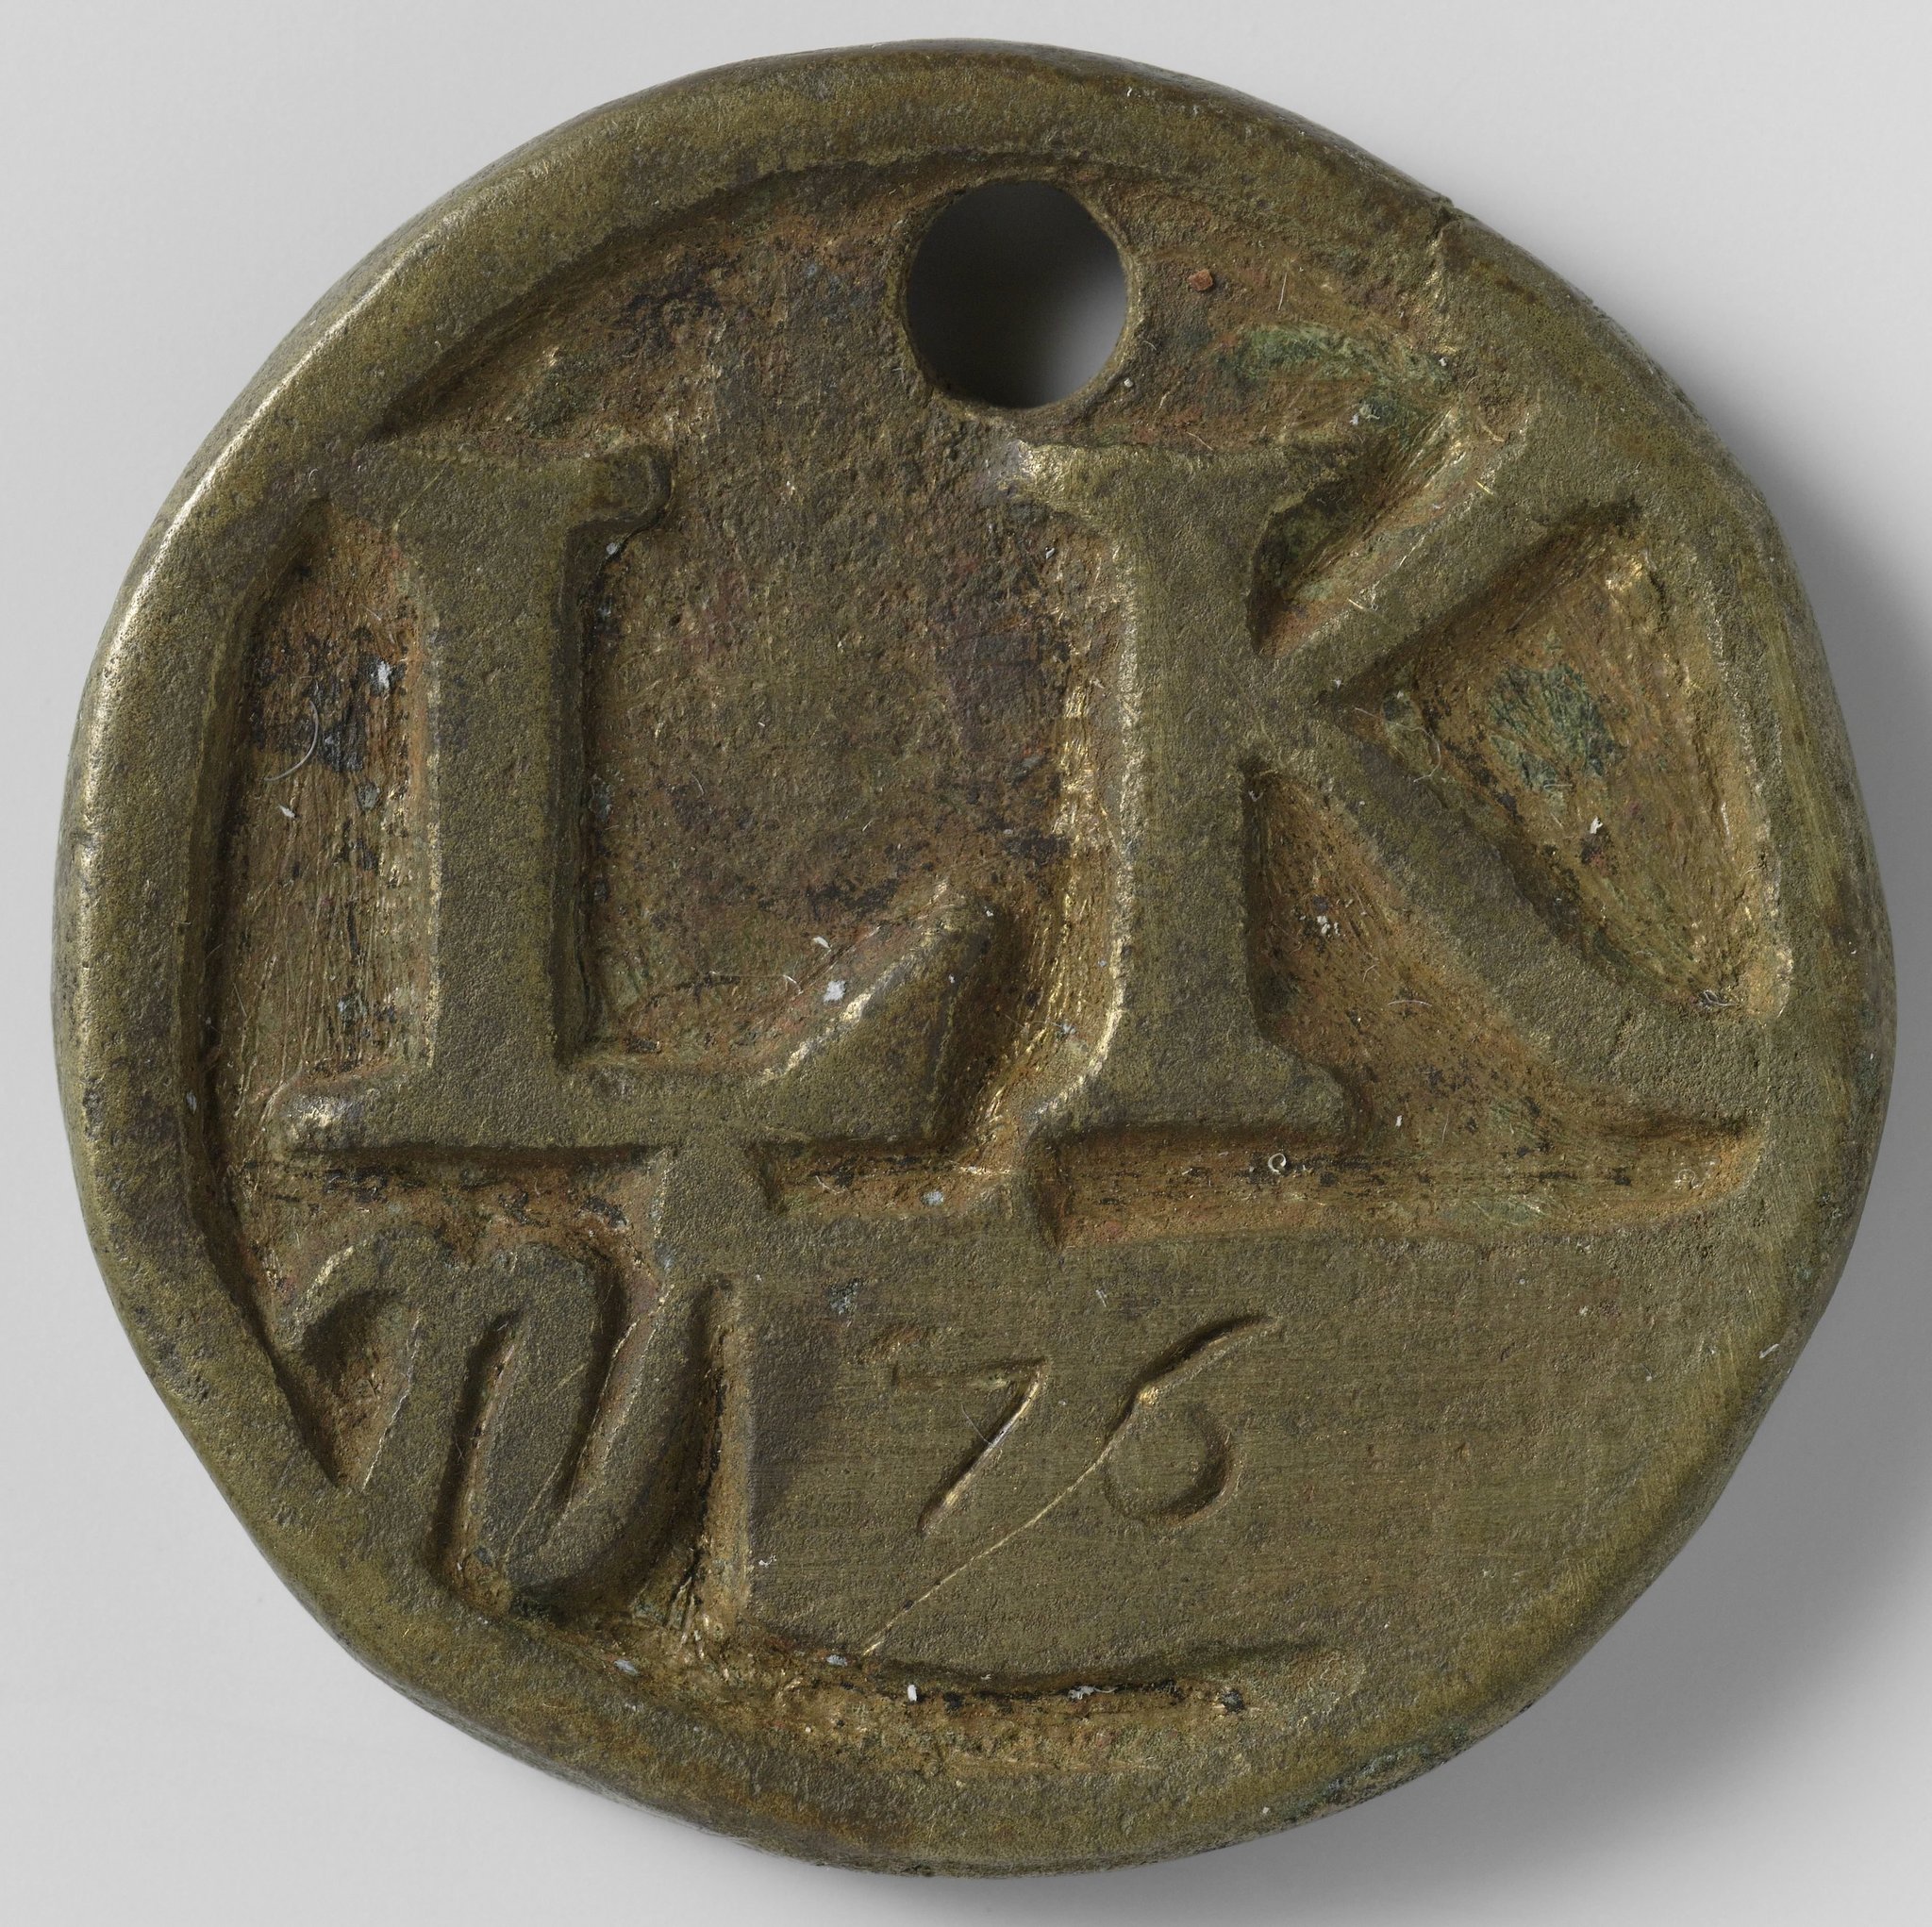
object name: toegangspenning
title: Bewijs van toegang tot de linnenkamer van het Diaconieweeshuis te Amsterdam, toegangspenning met no. 76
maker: Anonymous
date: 1656-1800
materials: brass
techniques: casting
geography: amsterdam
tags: amsterdam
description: Messing penning met gat erin. Voorzijde: letters DIA, boven letter W. Keerzijde: letters LK, daaronder nr. en cijfer 76